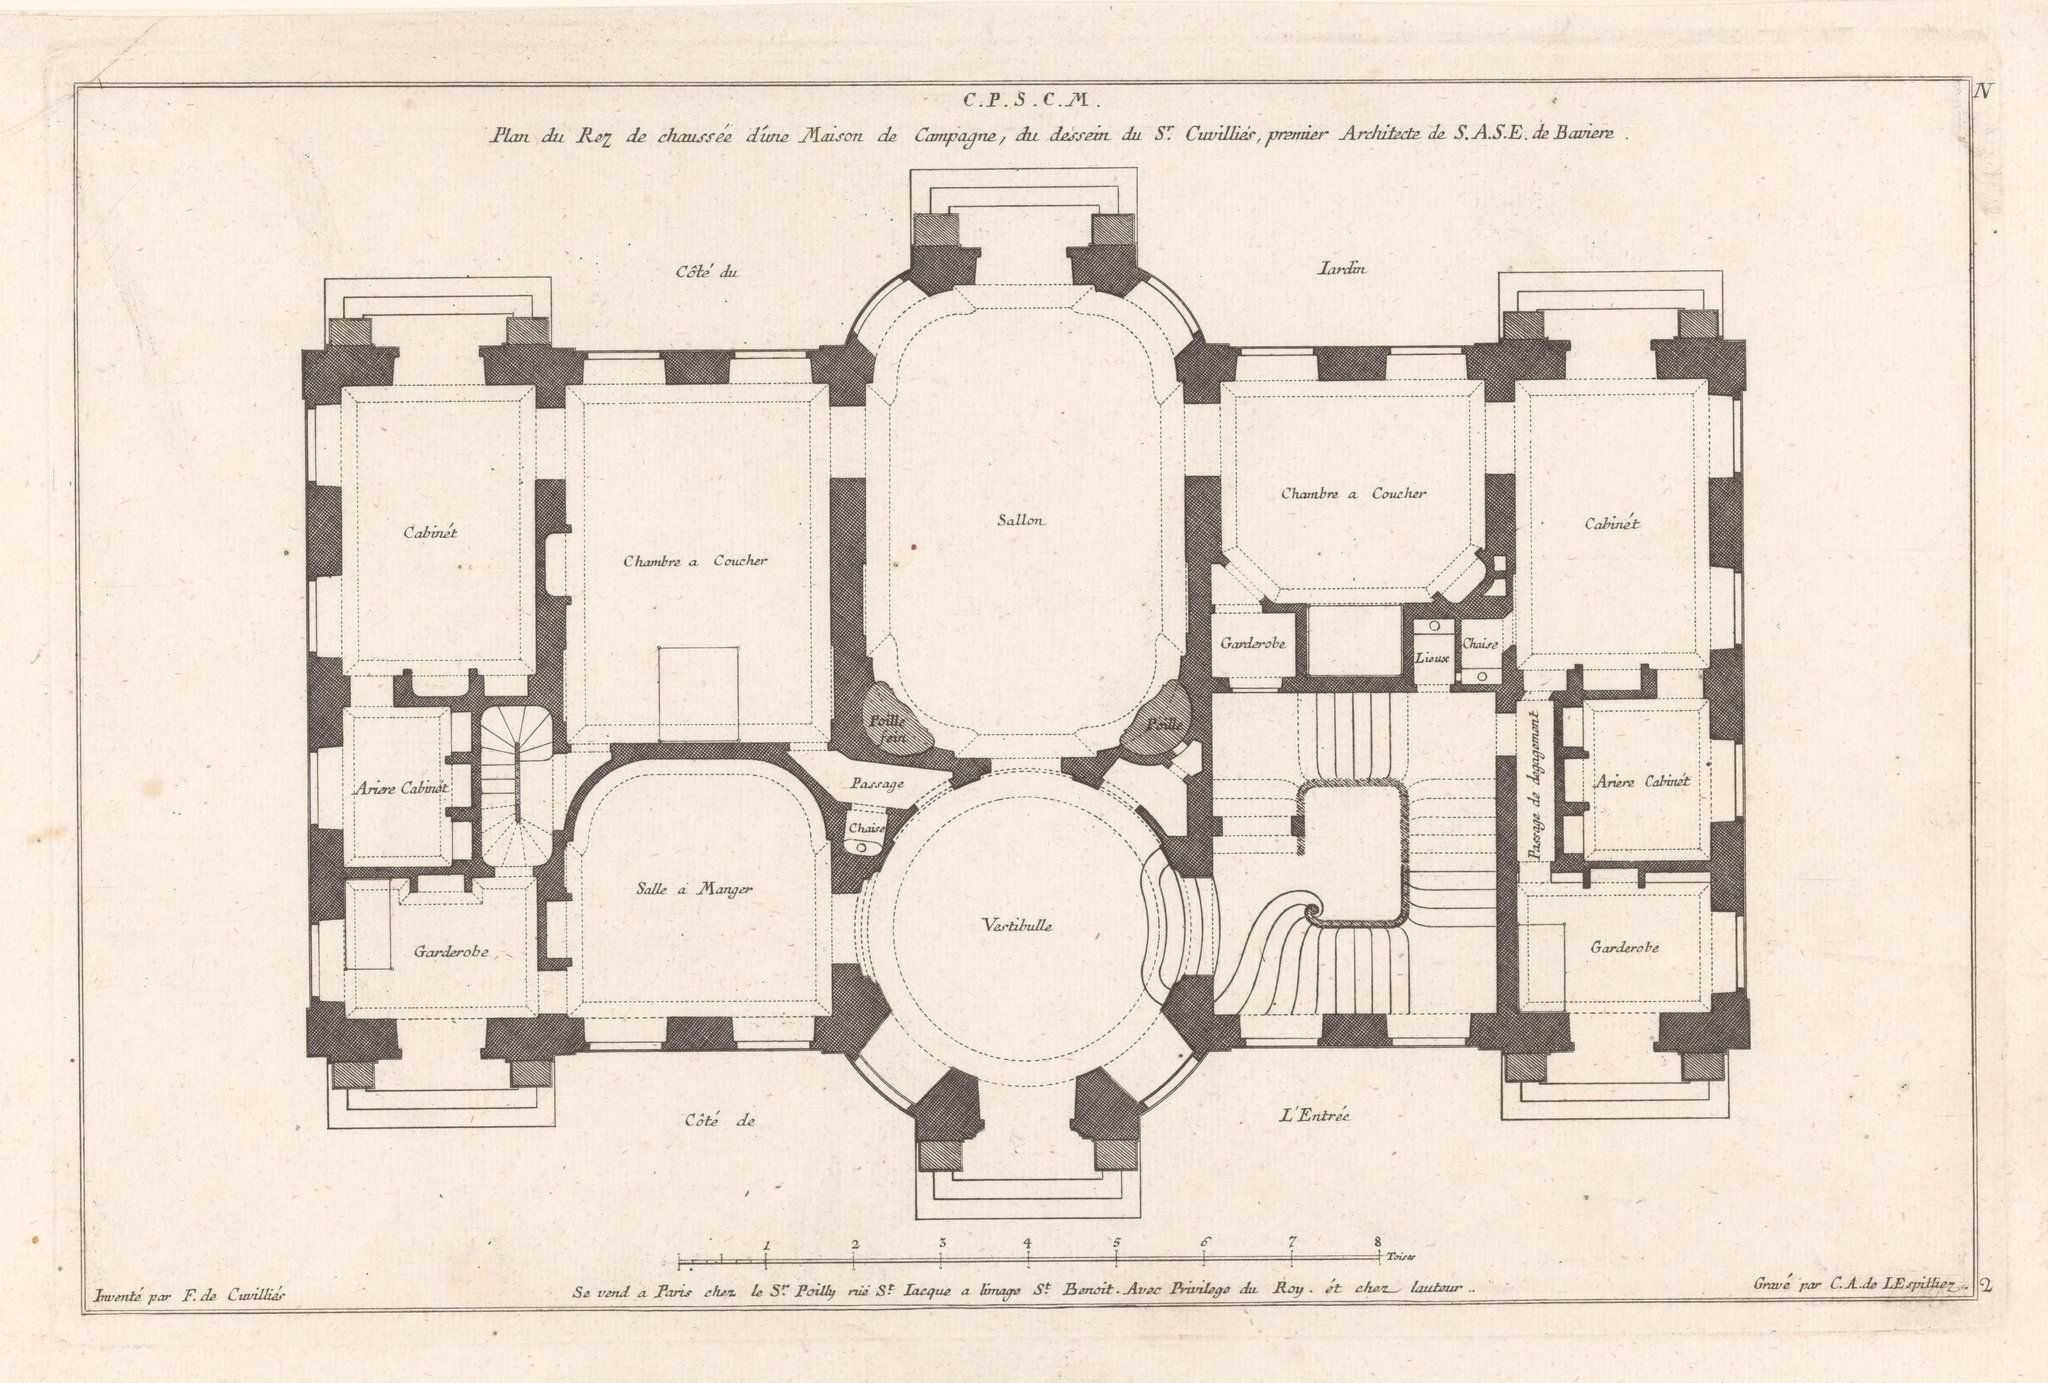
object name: print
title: 13me Livre N Plan (...) d'une Maison de Campagne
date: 1745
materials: paper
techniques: engraving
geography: germany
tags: plan ~ architecture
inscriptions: collector's mark: Lugt 2228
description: Plattegrond van de begane grond van een landhuis.